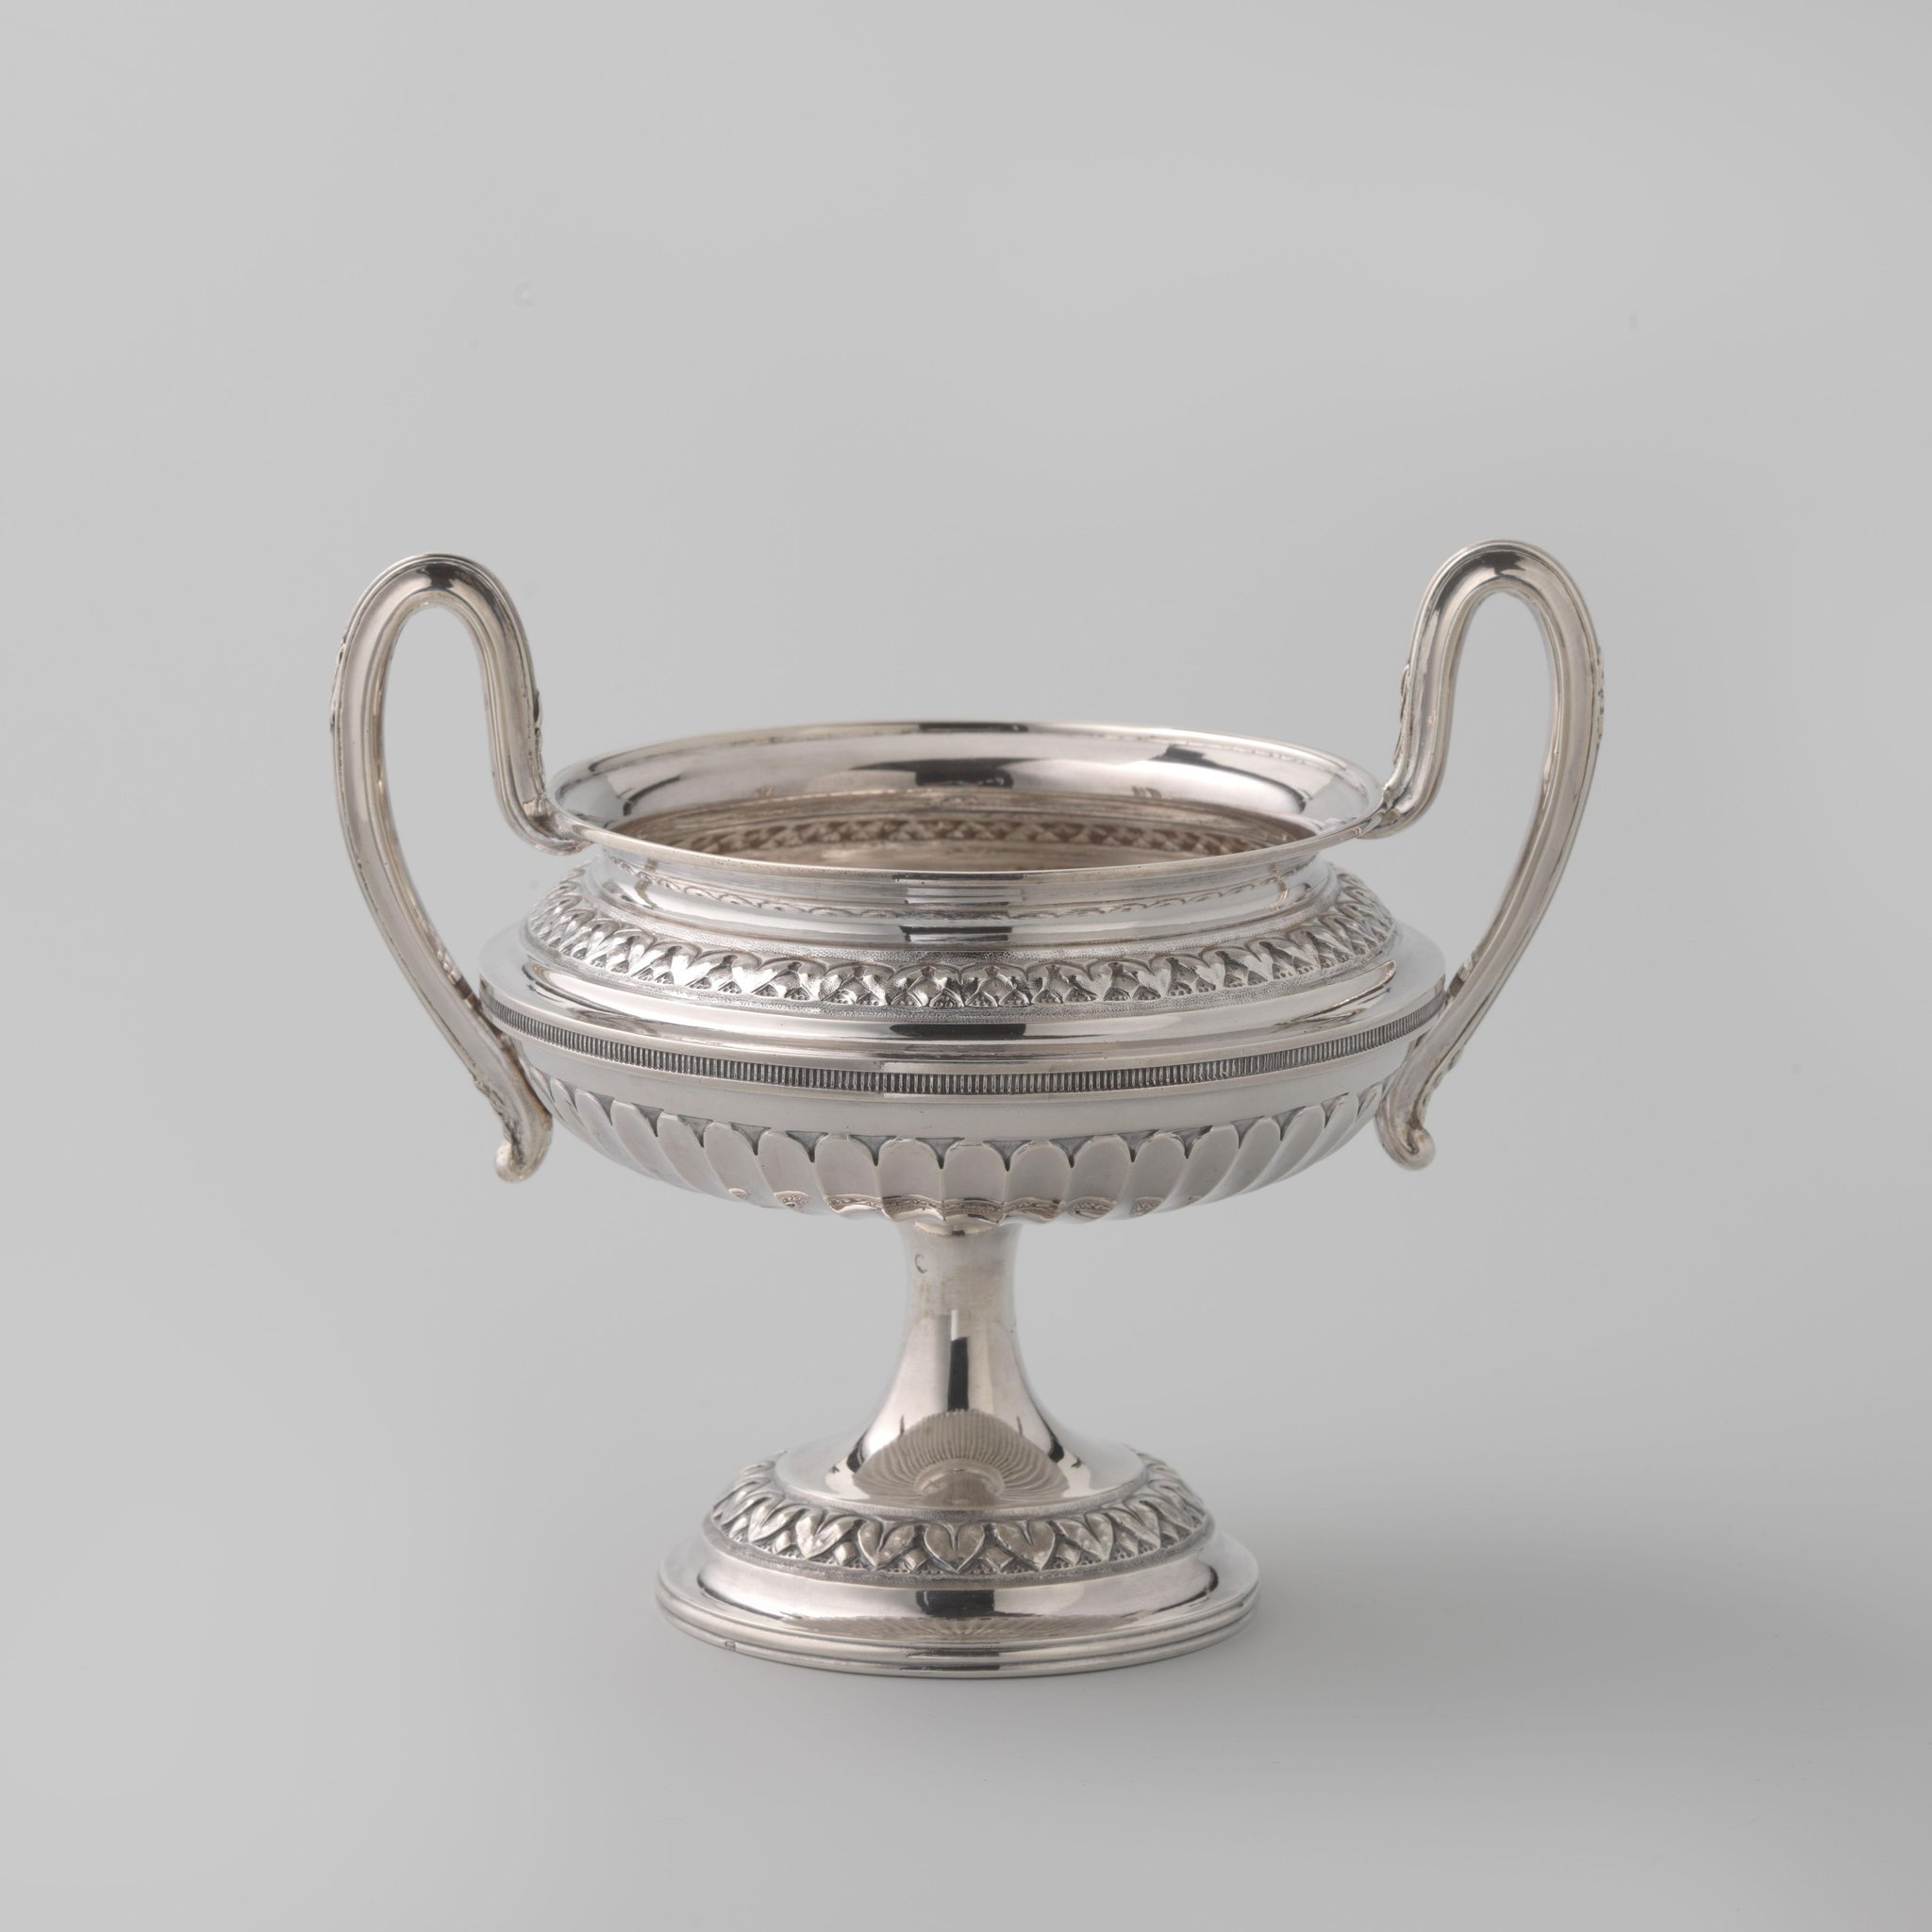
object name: suikervaas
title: Suikervaas, rond, met cannelures en acanthusblad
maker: lodewijk hendrik held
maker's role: silversmith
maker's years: 1858-1940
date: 1896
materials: silver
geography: amsterdam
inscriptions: assay office mark, maker's mark, alloy mark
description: Het servies bestaat uit een theepot (BK-15769) met S-vormig gebogen tuit en een vleugelvormig oor, een melkkan (BK-15770) met een soortgelijk kleiner oor en een brede lip, en een suikervaas (BK-15771) op voet met twee soortgelijke, nog kleinere oren. De ronde, zich naar boven verwijdende lichamen van thee- en suikerpot zijn versierd met cannelures, aan de bovenzijde begrensd door een gladde rand, waarboven een iets uitstekende geribde rand. De bovenzijde is opgebouwd uit een brede, iets holle band, een smalle, horizontale, geponste rand, een licht gebold fries van acanthusblad op een gestippeld fond en een smalle geponste rand. Bij de theepot bevindt zich daarboven een opstaande geprofileerde bovenrand, waarin het losse deksel valt. Dit bestaat uit een glad, zich naar boven versmallend ondergedeelte met daarop een klokvormig gedeelte dat aan de bovenzijde gevat is in acanthusblad en aan de onderzijde is begrensd door een parelrand. Hierop rust, verbonden door een diabolovormig tussenstuk, een eikelvormig knopje. De melkkan heeft een diabolovormige hals die overgaat in een brede lip met gelobde rand. De voet van de ronde suikervaas rust op een rechte, geprofileerde basis. Het gedeelte hierboven is zeer verwant aan de bovenzijde van de theepot en de melkkan: een holle band, smalle, horizontale, geponste rand, licht gebolde fries van acanthusblad en smalle geponste rand. Daarboven bevindt zich een glad, naar boven smal toelopend gedeelte waarop de gedrukt bolvormige bak rust, die versierd is zoals de theepot. Boven de acanthusrand bevindt zich een hol uitstaande bovenrand. Alle oren hebben aan de zijkanten holle profielen- en aan de bovenzijde ribbels, op drie plaatsen onderbroken door schuin geplaatste eikenbladen. Het palissanderhouten oor van de theepot heeft voluutvormige zilveren vattingen. De tuit van de theepot is versierd met vier brede groeven.